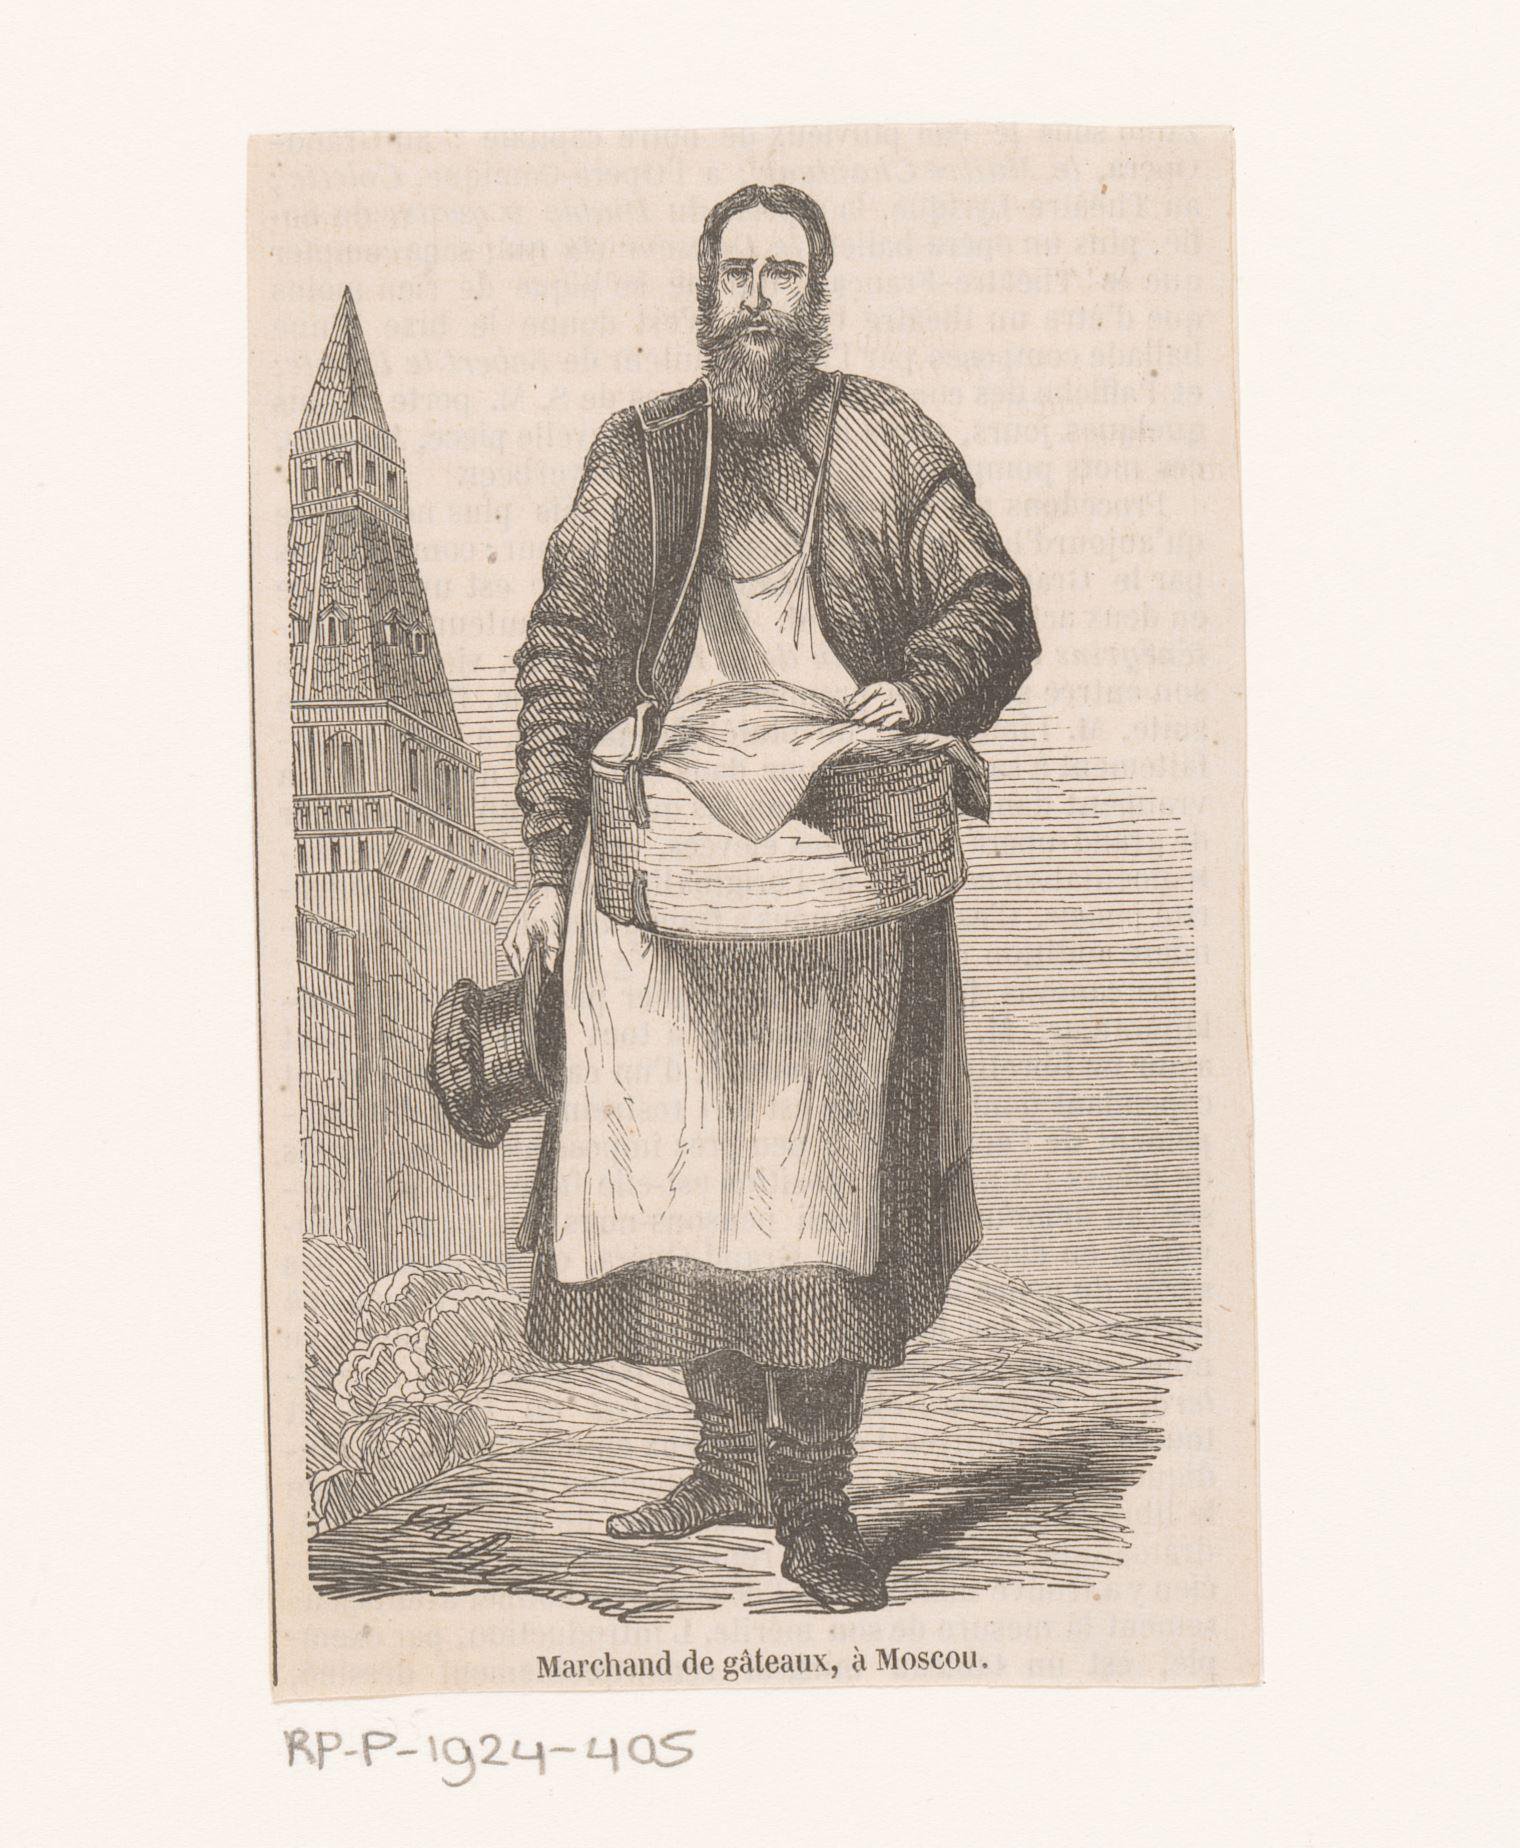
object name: print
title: Marchand de gâteaux, à Moscou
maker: ch. reboul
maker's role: print maker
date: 1826-1899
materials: paper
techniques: letterpress printing, engraving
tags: pie, europeans (with name), merchant, salesman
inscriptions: collector's mark: Lugt 2233